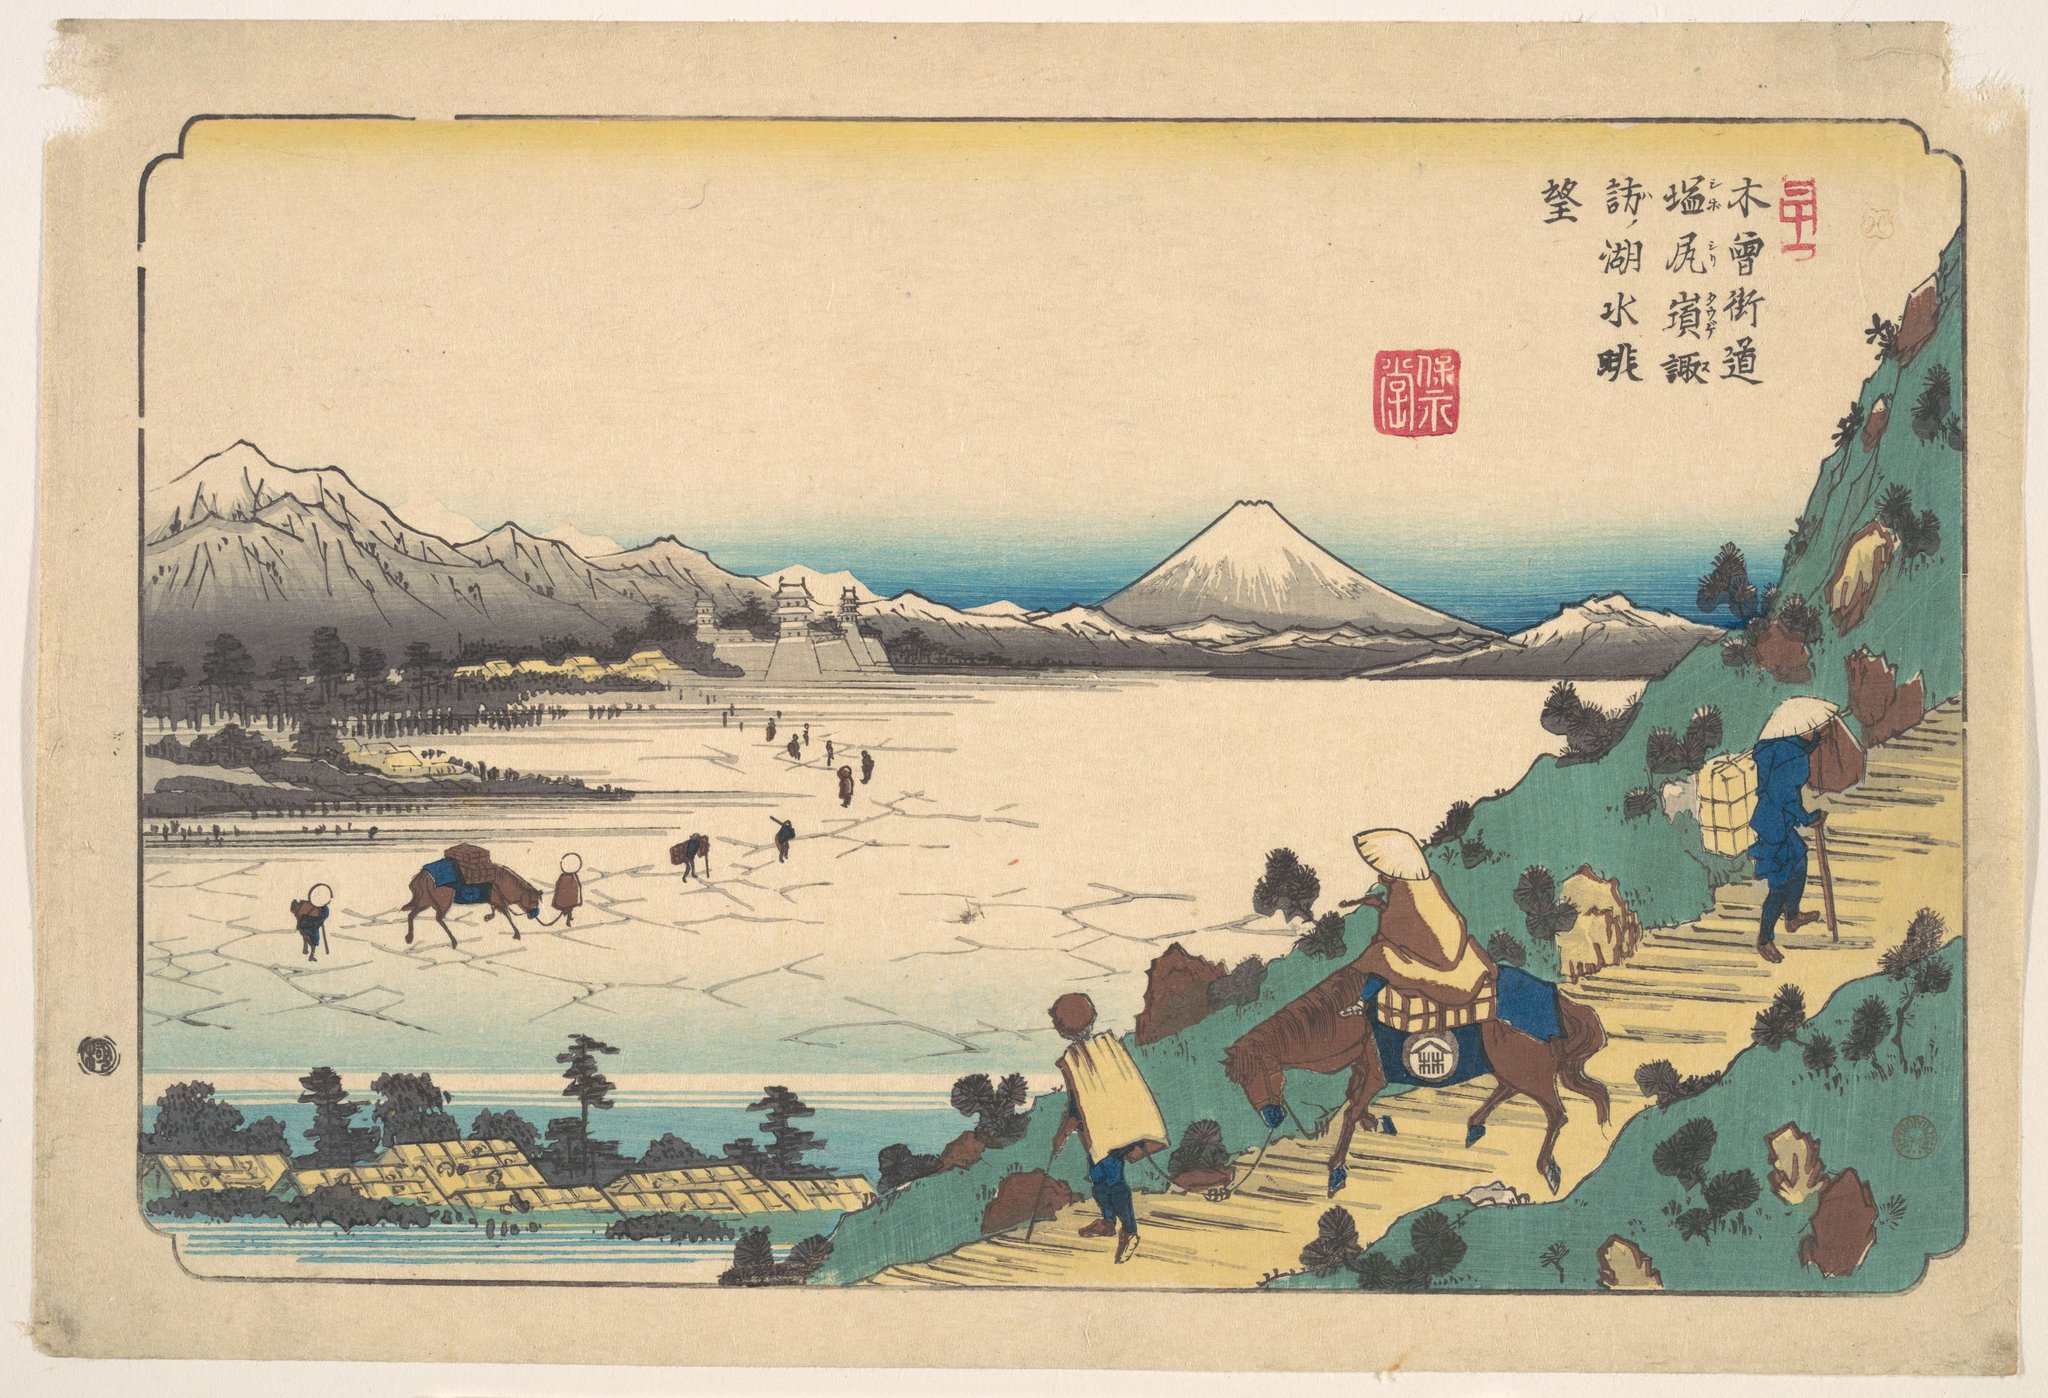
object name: print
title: Lake Suwa from Shiojiri Pass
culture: japanese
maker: keisai eisen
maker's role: artist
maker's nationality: japanese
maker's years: 1790-1848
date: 1835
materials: ink, paper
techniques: woodblock print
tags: human figures,horses,lakes,mountains